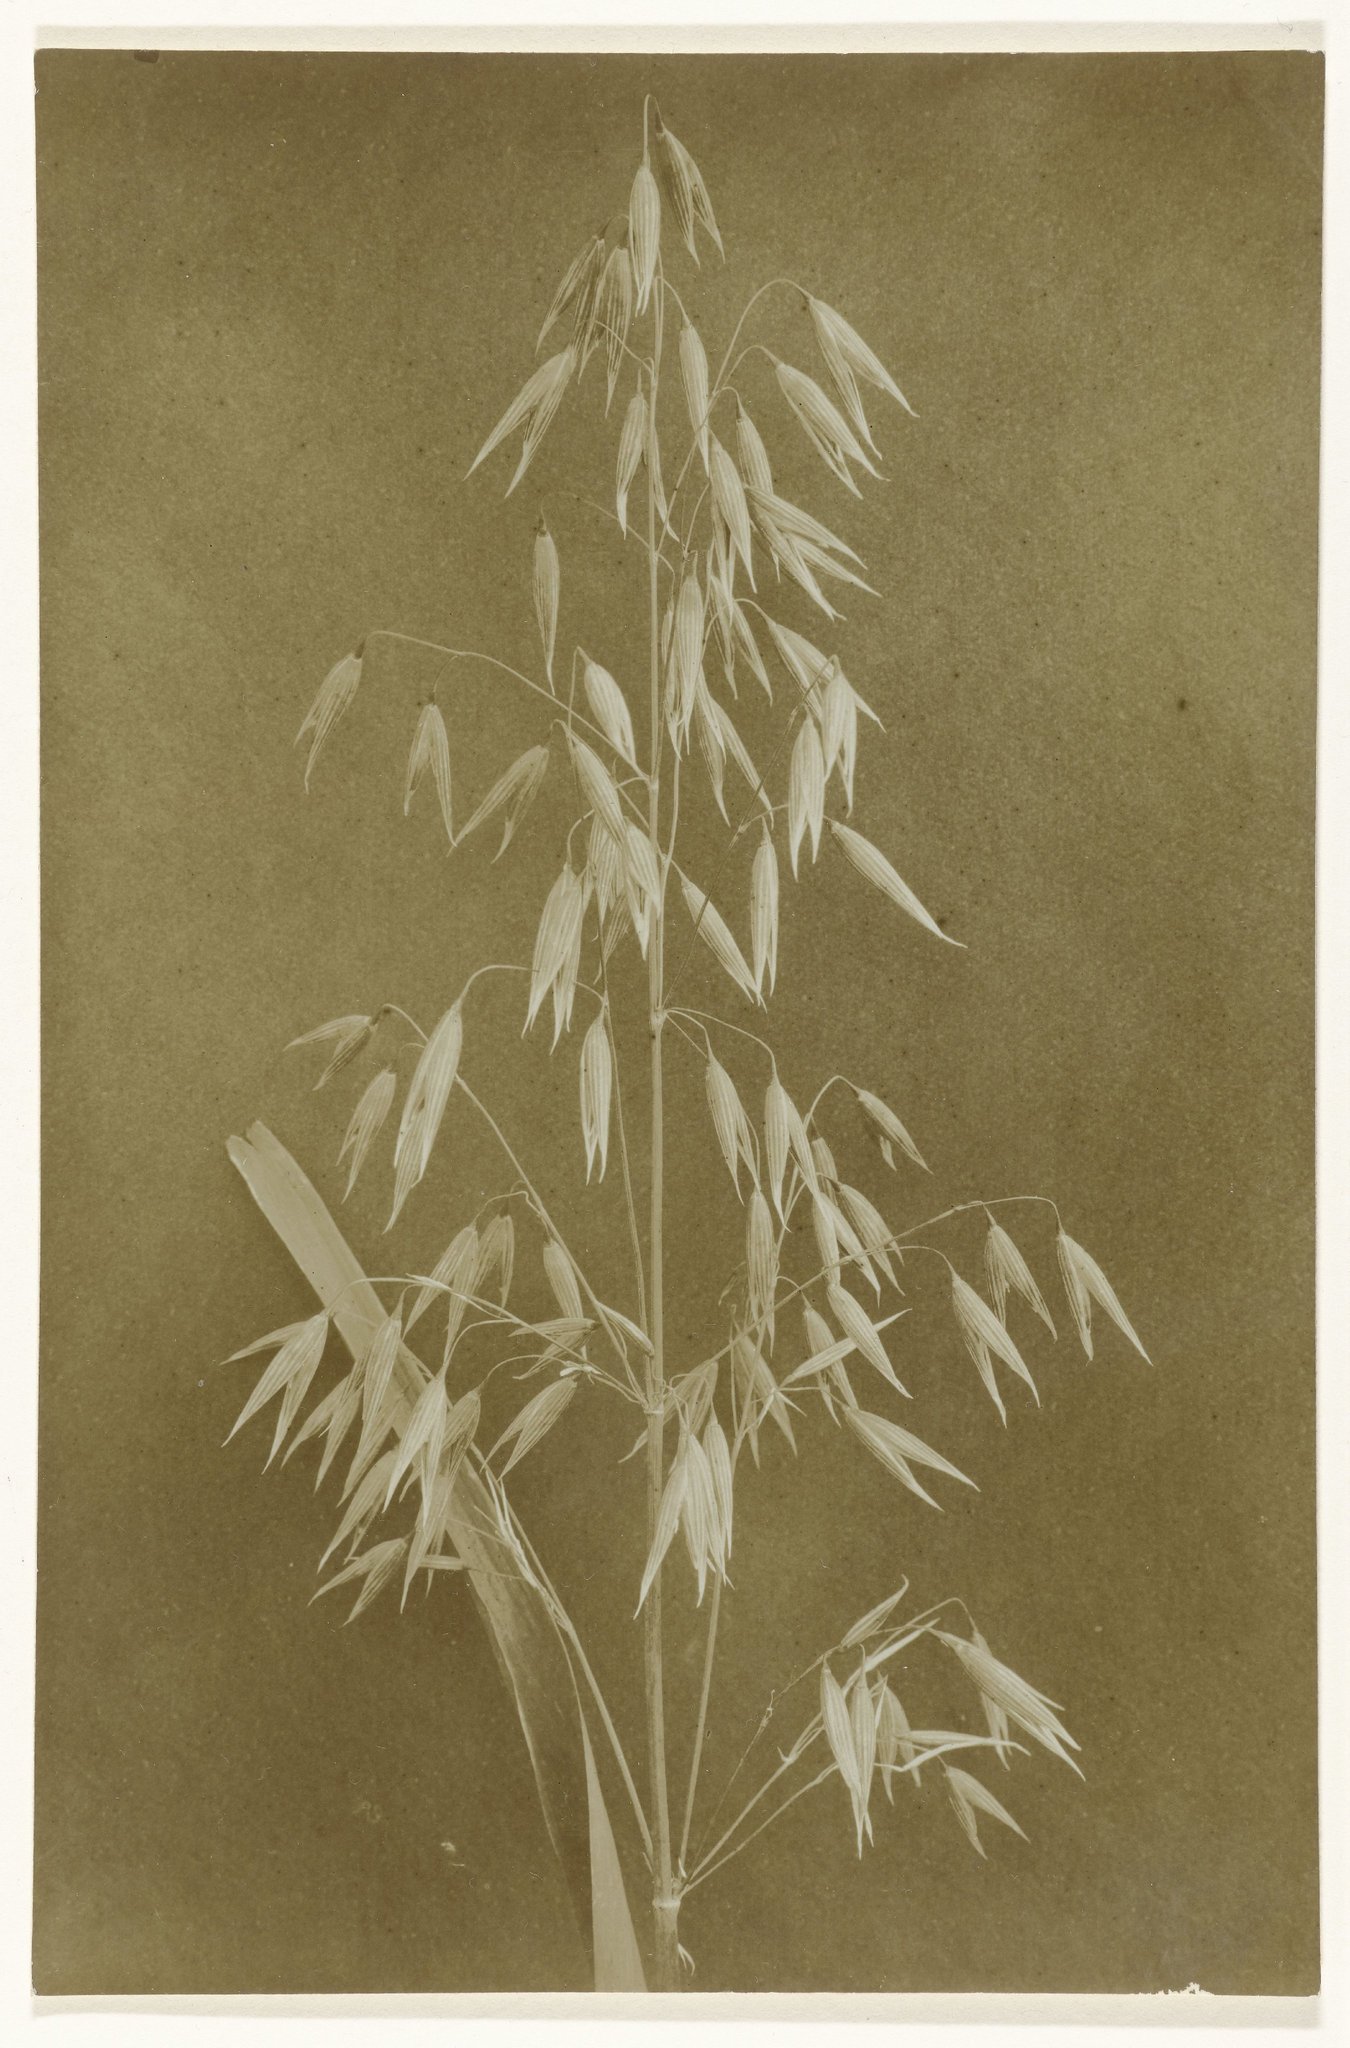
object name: photograph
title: Haver aar in bloei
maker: richard tepe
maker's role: fotograaf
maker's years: 1864-1952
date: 1900-1930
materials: photographic support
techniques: gelatin silver print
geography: netherlands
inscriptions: annotation: ‘Haver-Aar’, signature: ‘foto / R Tepe’